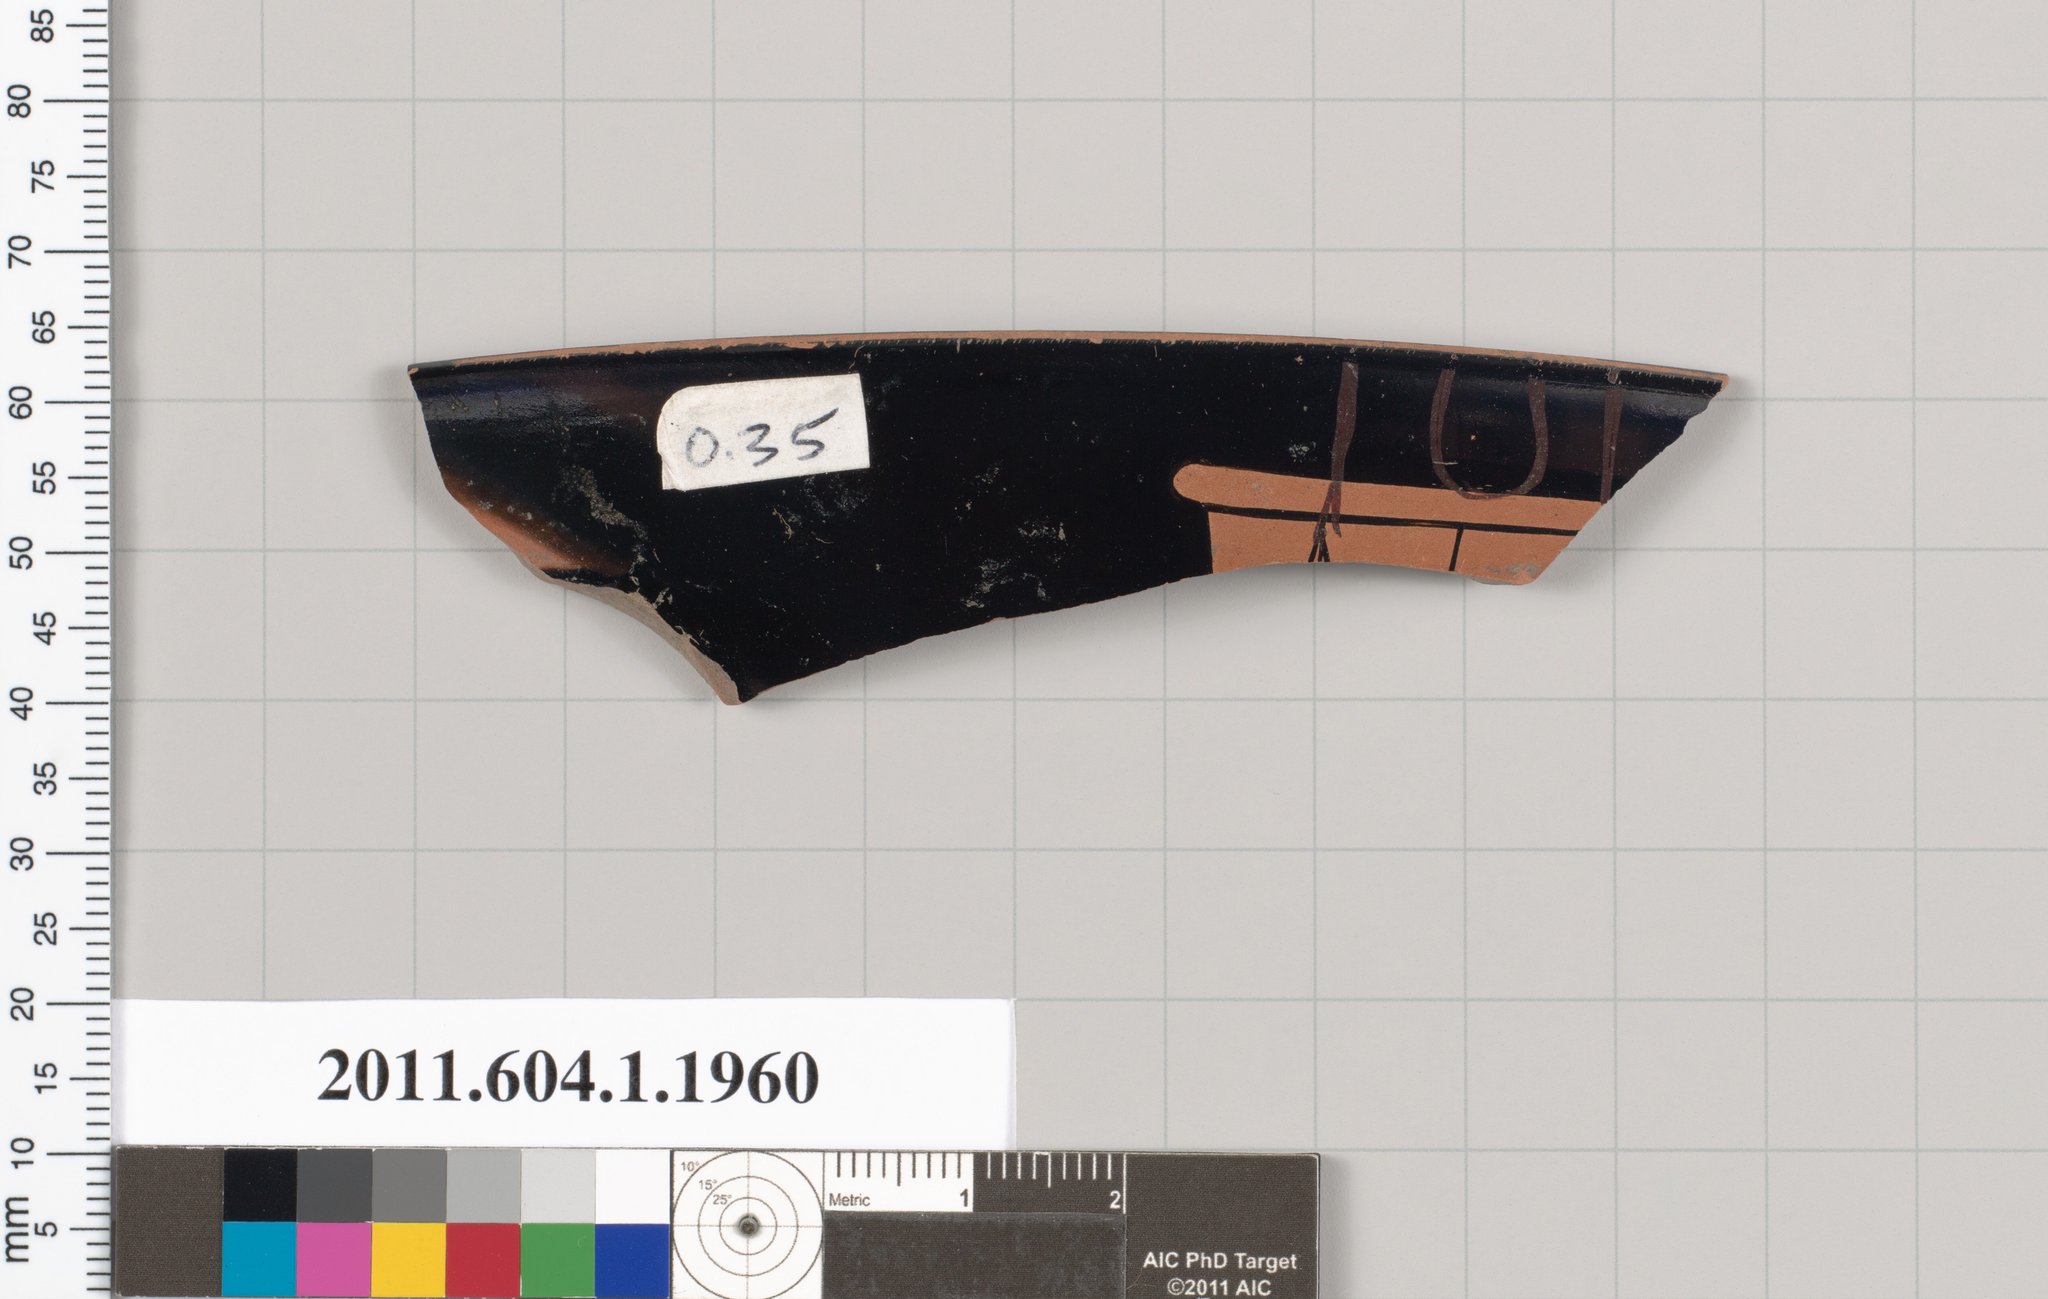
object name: kylix fragment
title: Terracotta rim fragment of a kylix (drinking cup)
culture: greek, attic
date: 490-480 BCE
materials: terracotta